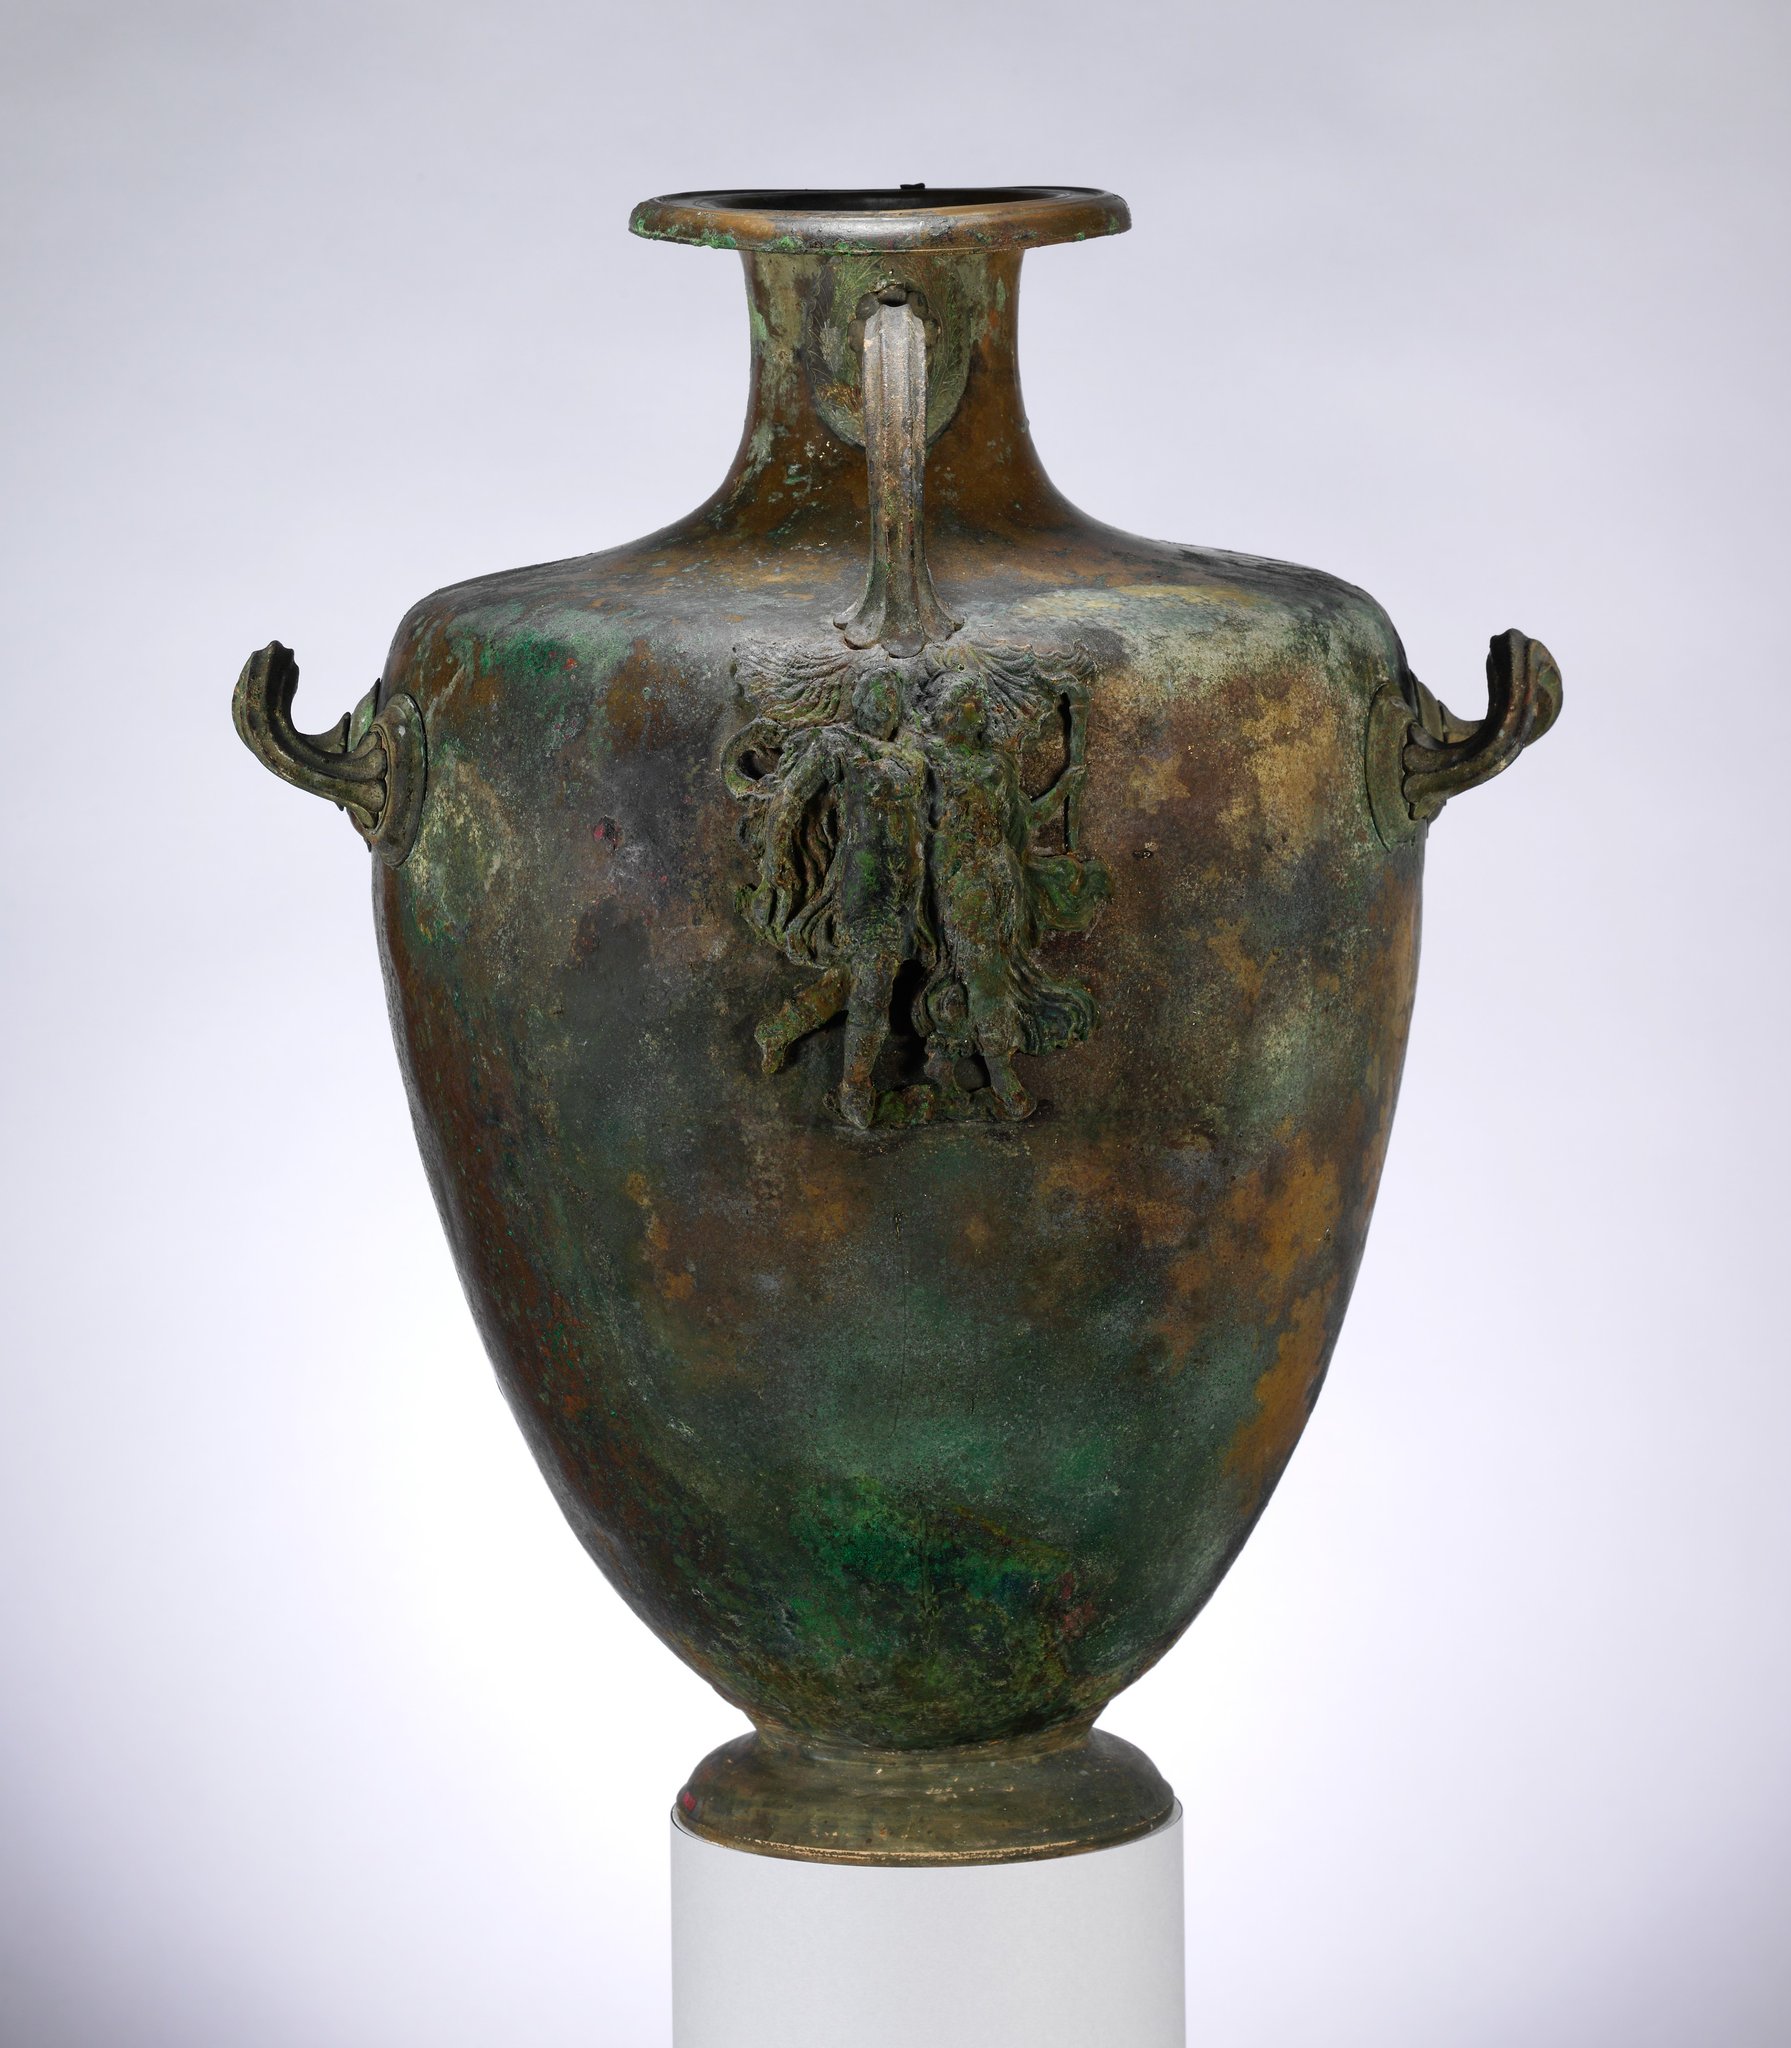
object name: hydria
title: Bronze hydria (water jar)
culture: greek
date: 367-335 BCE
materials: bronze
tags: dionysus,eros,ariadne